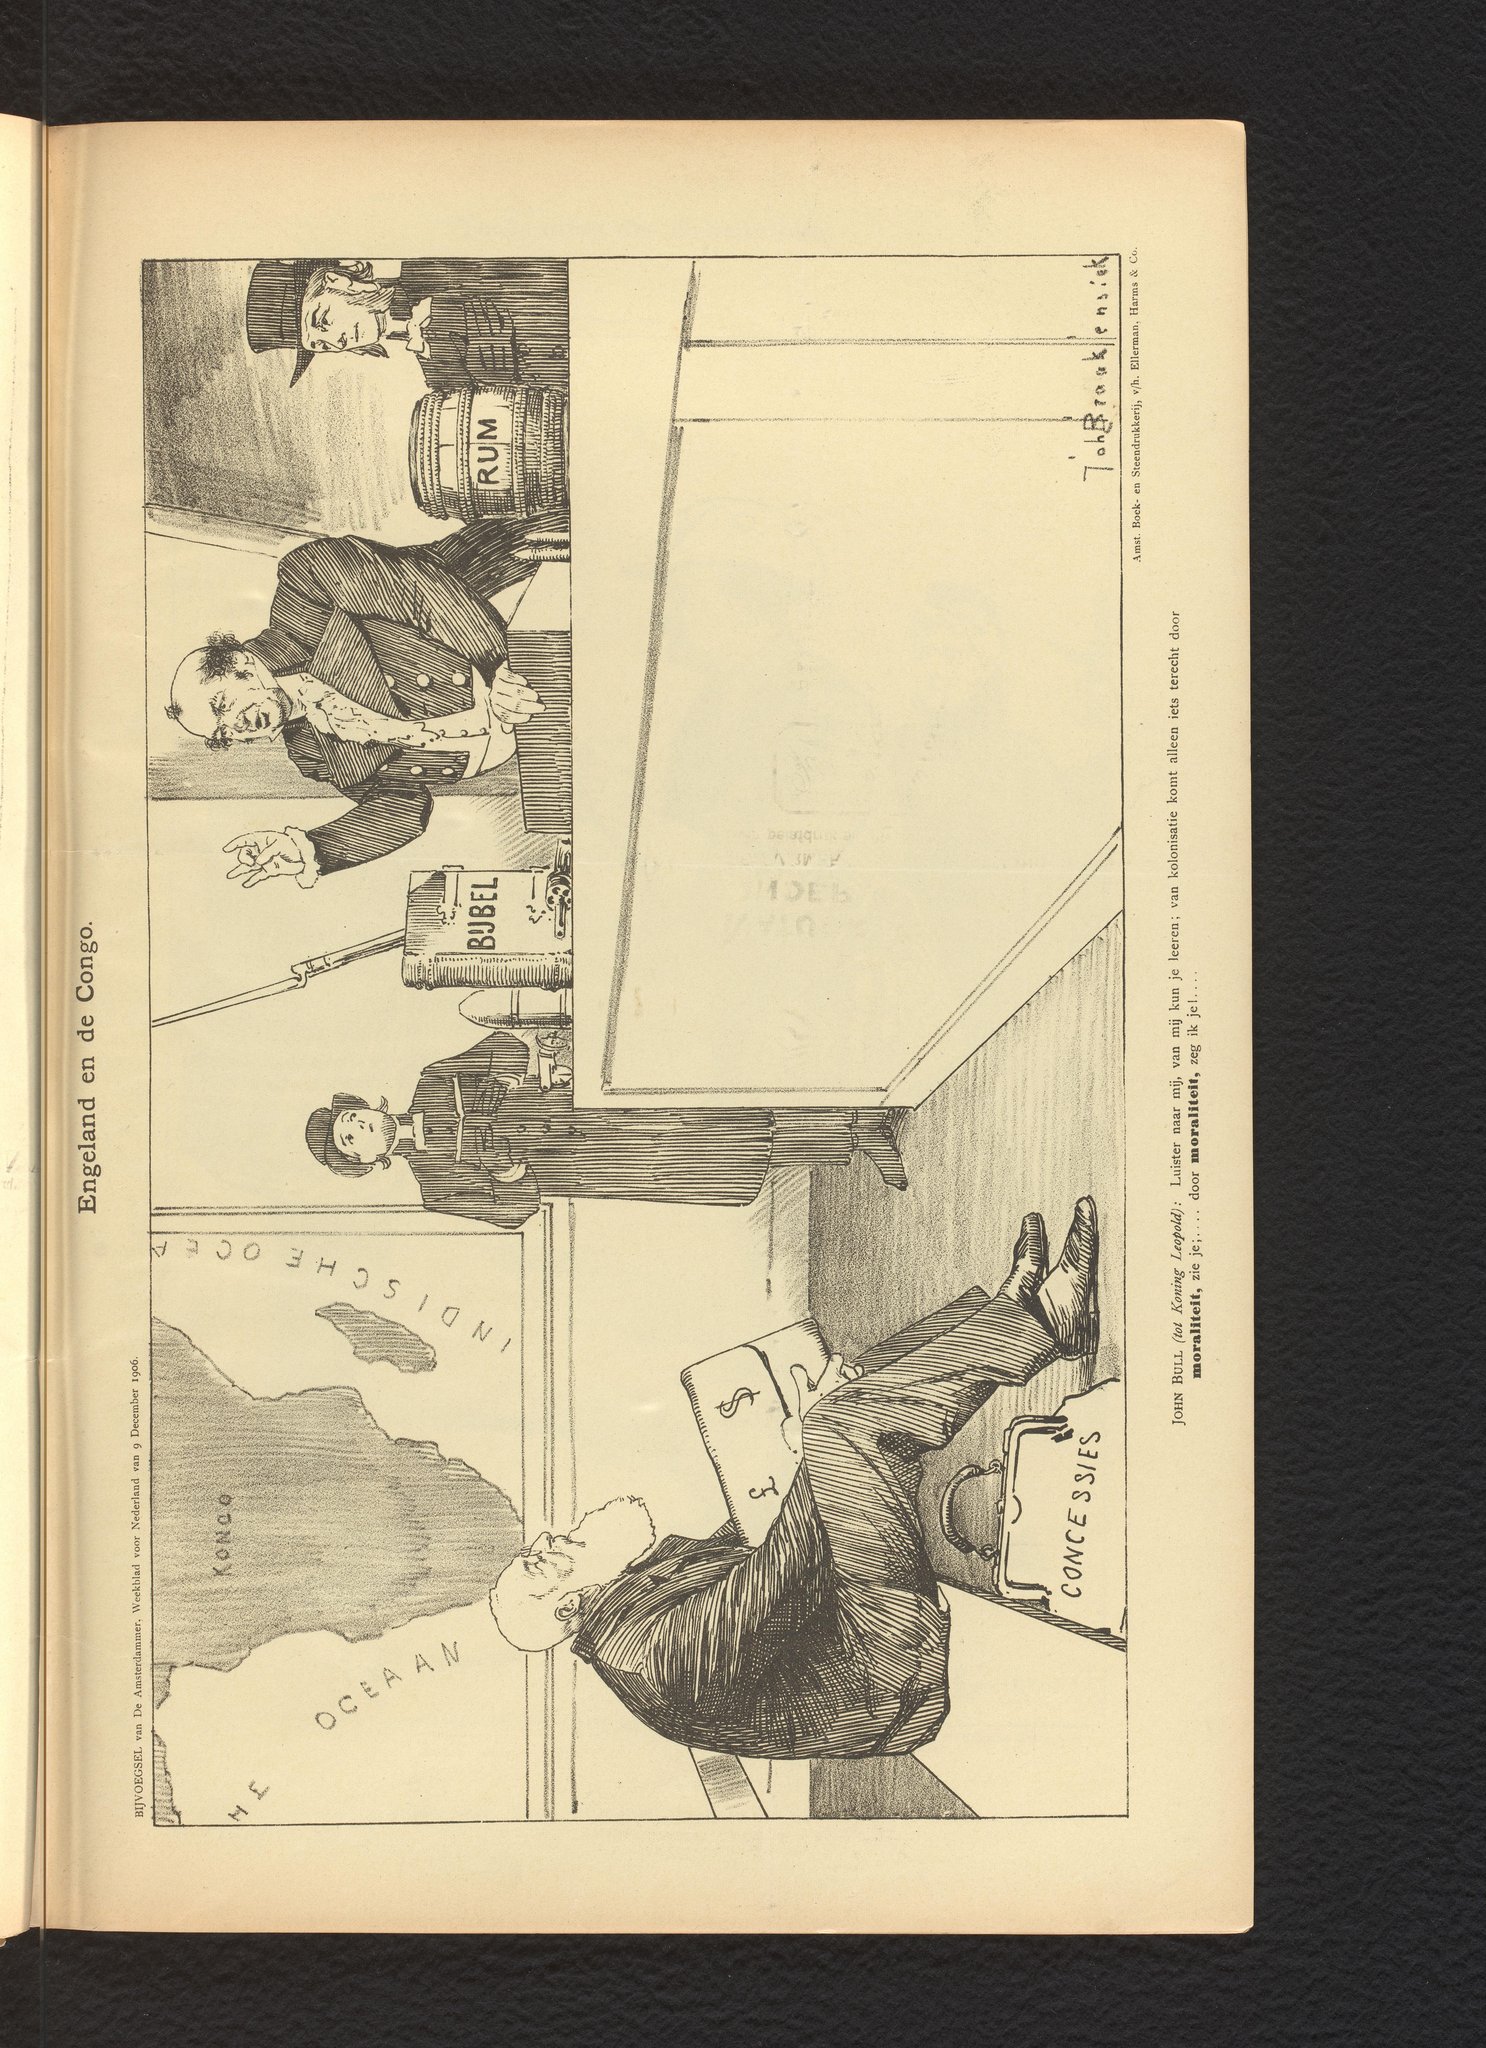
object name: cartoon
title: Engeland en de Congo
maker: johan braakensiek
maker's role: draughtsman, print maker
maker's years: 1858-1940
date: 1906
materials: paper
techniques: lithograph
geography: amsterdam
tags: leopold ii (koning der belgen), imperialism, personifications of countries, nations, states, districts, etc., political caricatures and satires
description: John Bull (Engeland) preekt vanachter een balie, waarop een Bijbel, rum, wapens en kogels staan, aan de Belgische koning Leopold II dat je het beste kunt koloniseren met moraliteit. Op de achtergrond een kaart van Afrika met Kongo.